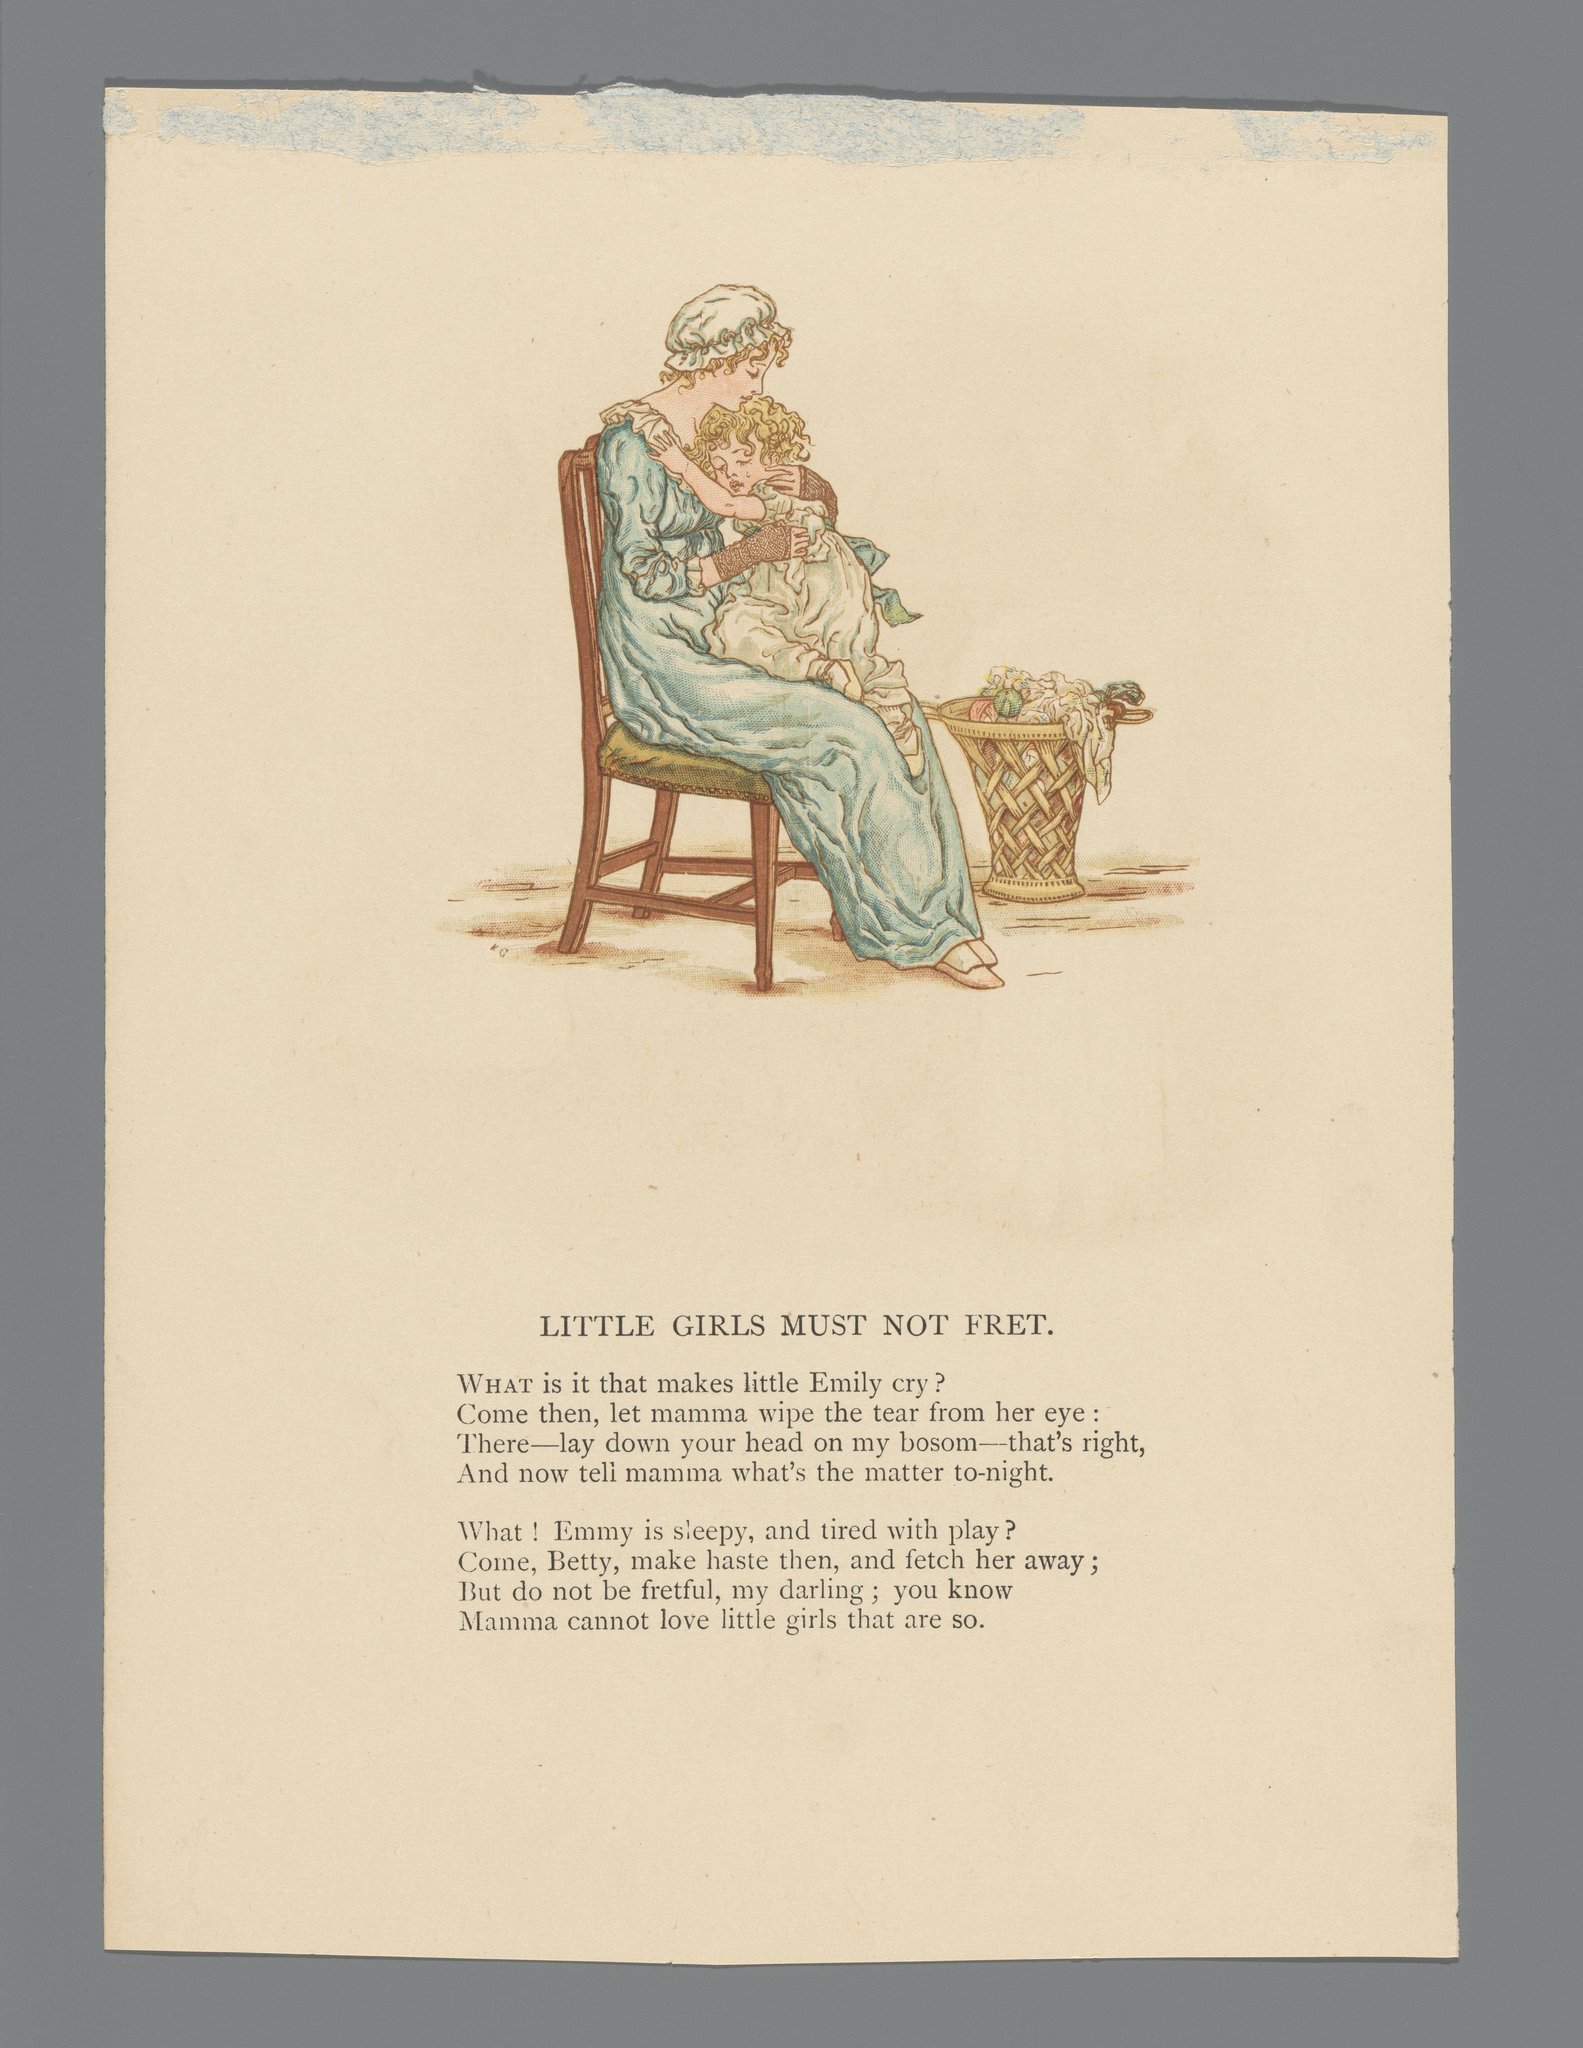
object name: book illustration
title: Vrouw met kind op schoot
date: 1883-1927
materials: paper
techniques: wood engraving, letterpress printing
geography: london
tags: chair, sitting in someone's lap, mother and child(ren), woman and child(ren) (family group)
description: Prent uit: Jane en Ann Taylor. Little Ann and other poems. Londen: George Routledge & Sons, [1883], p. 52. Of een latere uitgave.